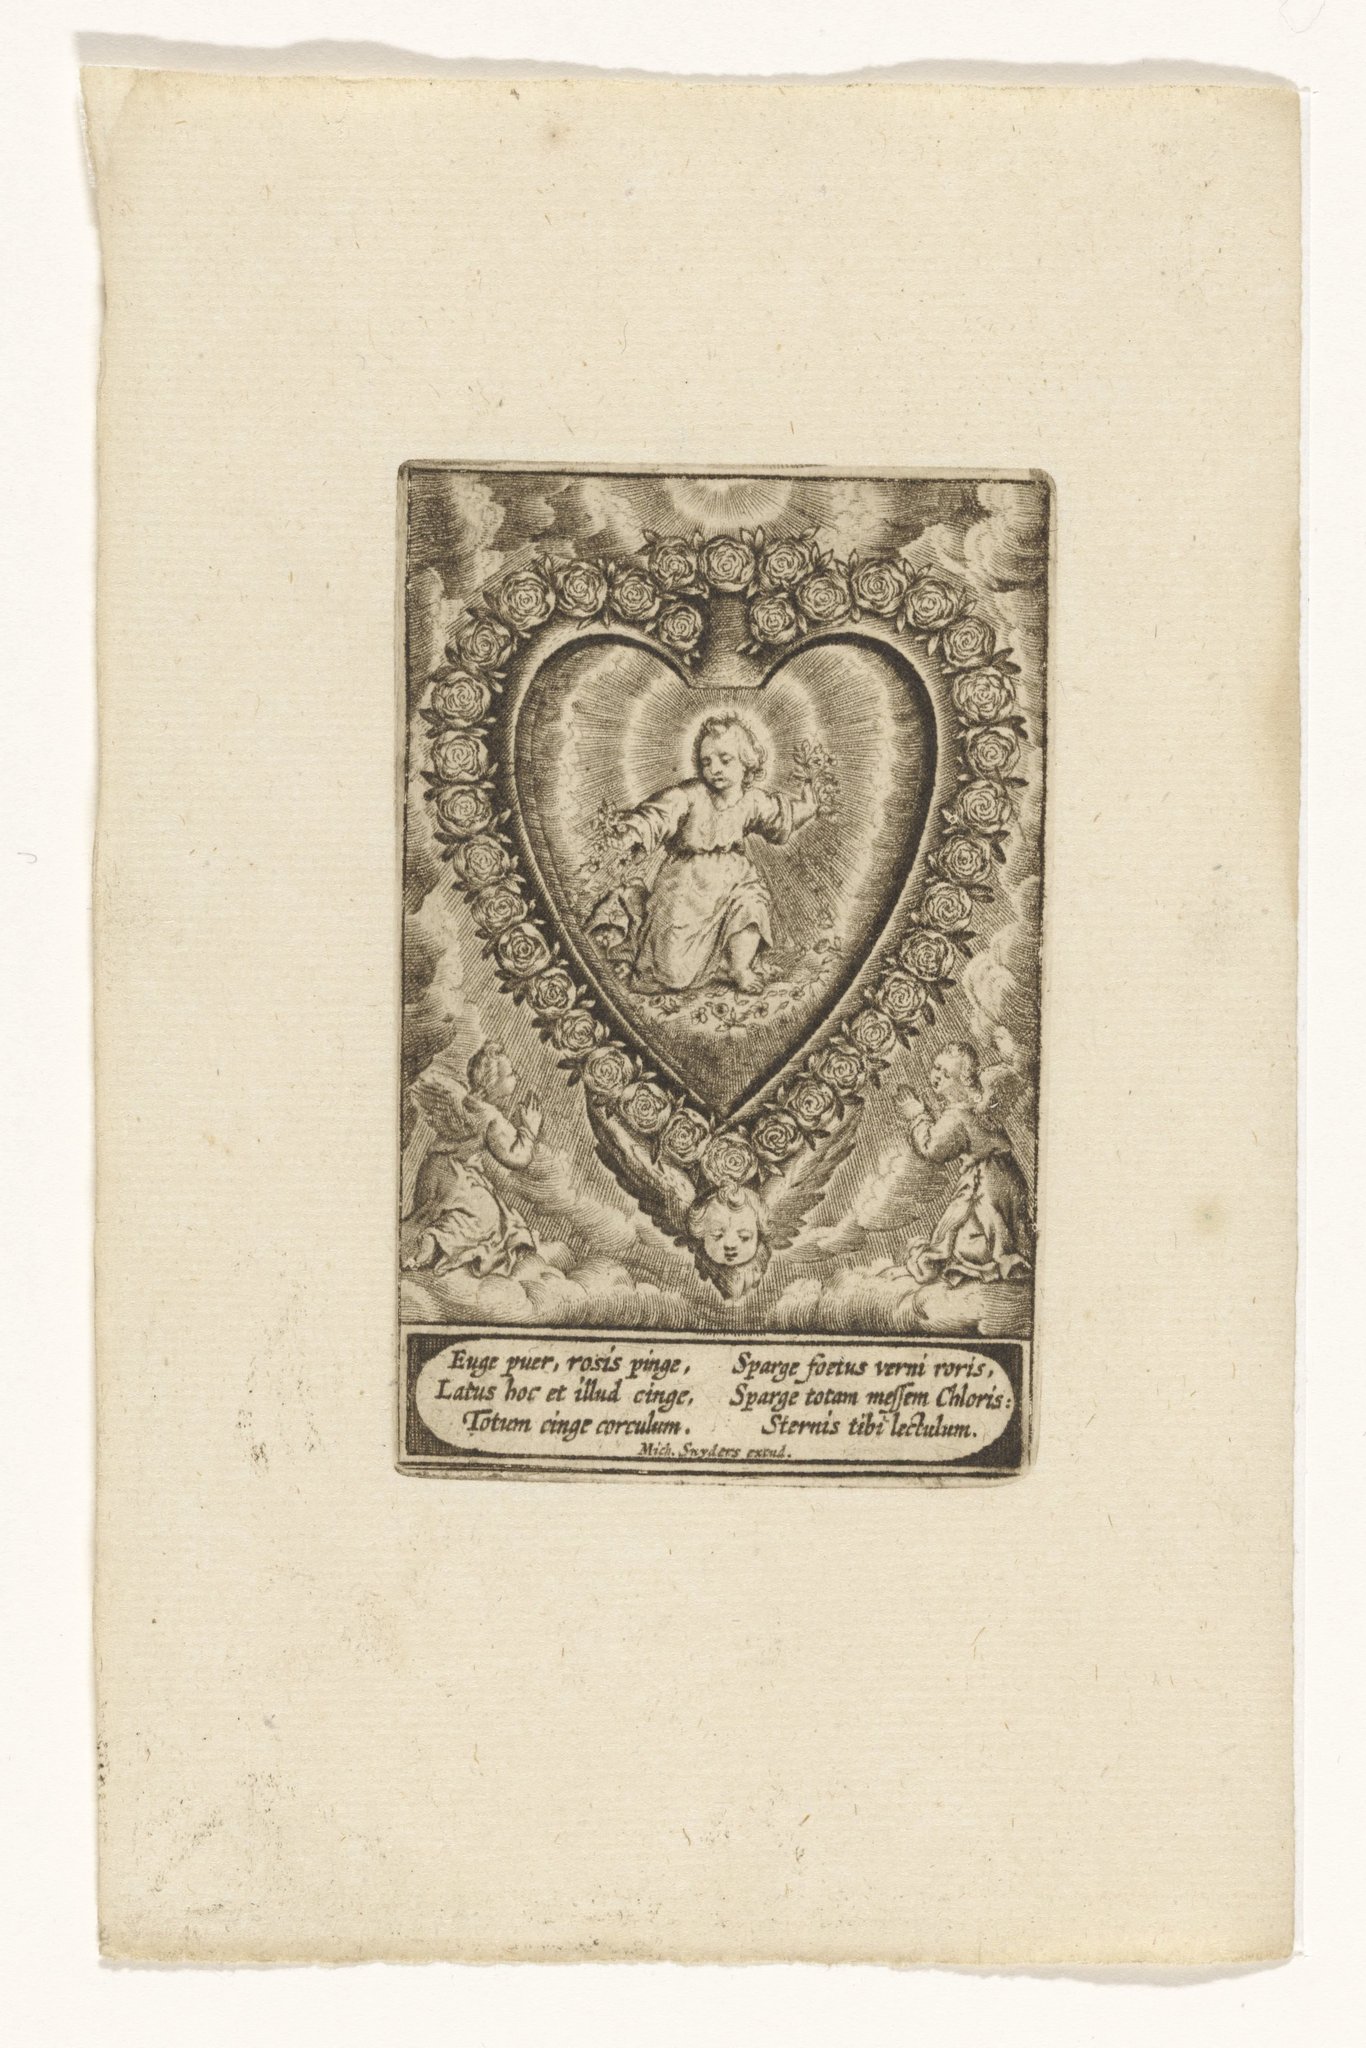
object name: print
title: Cor Iesu amanti sacrum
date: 1630-1650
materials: paper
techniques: engraving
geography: antwerp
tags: the sacred heart, regular clerics, e.g. jesuits, redemptorists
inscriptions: collector's mark: Lugt 2228, collector's mark: Lugt 2760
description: Het gezegende heilige hart omgeven door rozen. Onderdeel van een serie van zeventien prenten over het menselijke hart overwonnen door het Christuskind, een thema gerelateerd aan de jezuïeten.